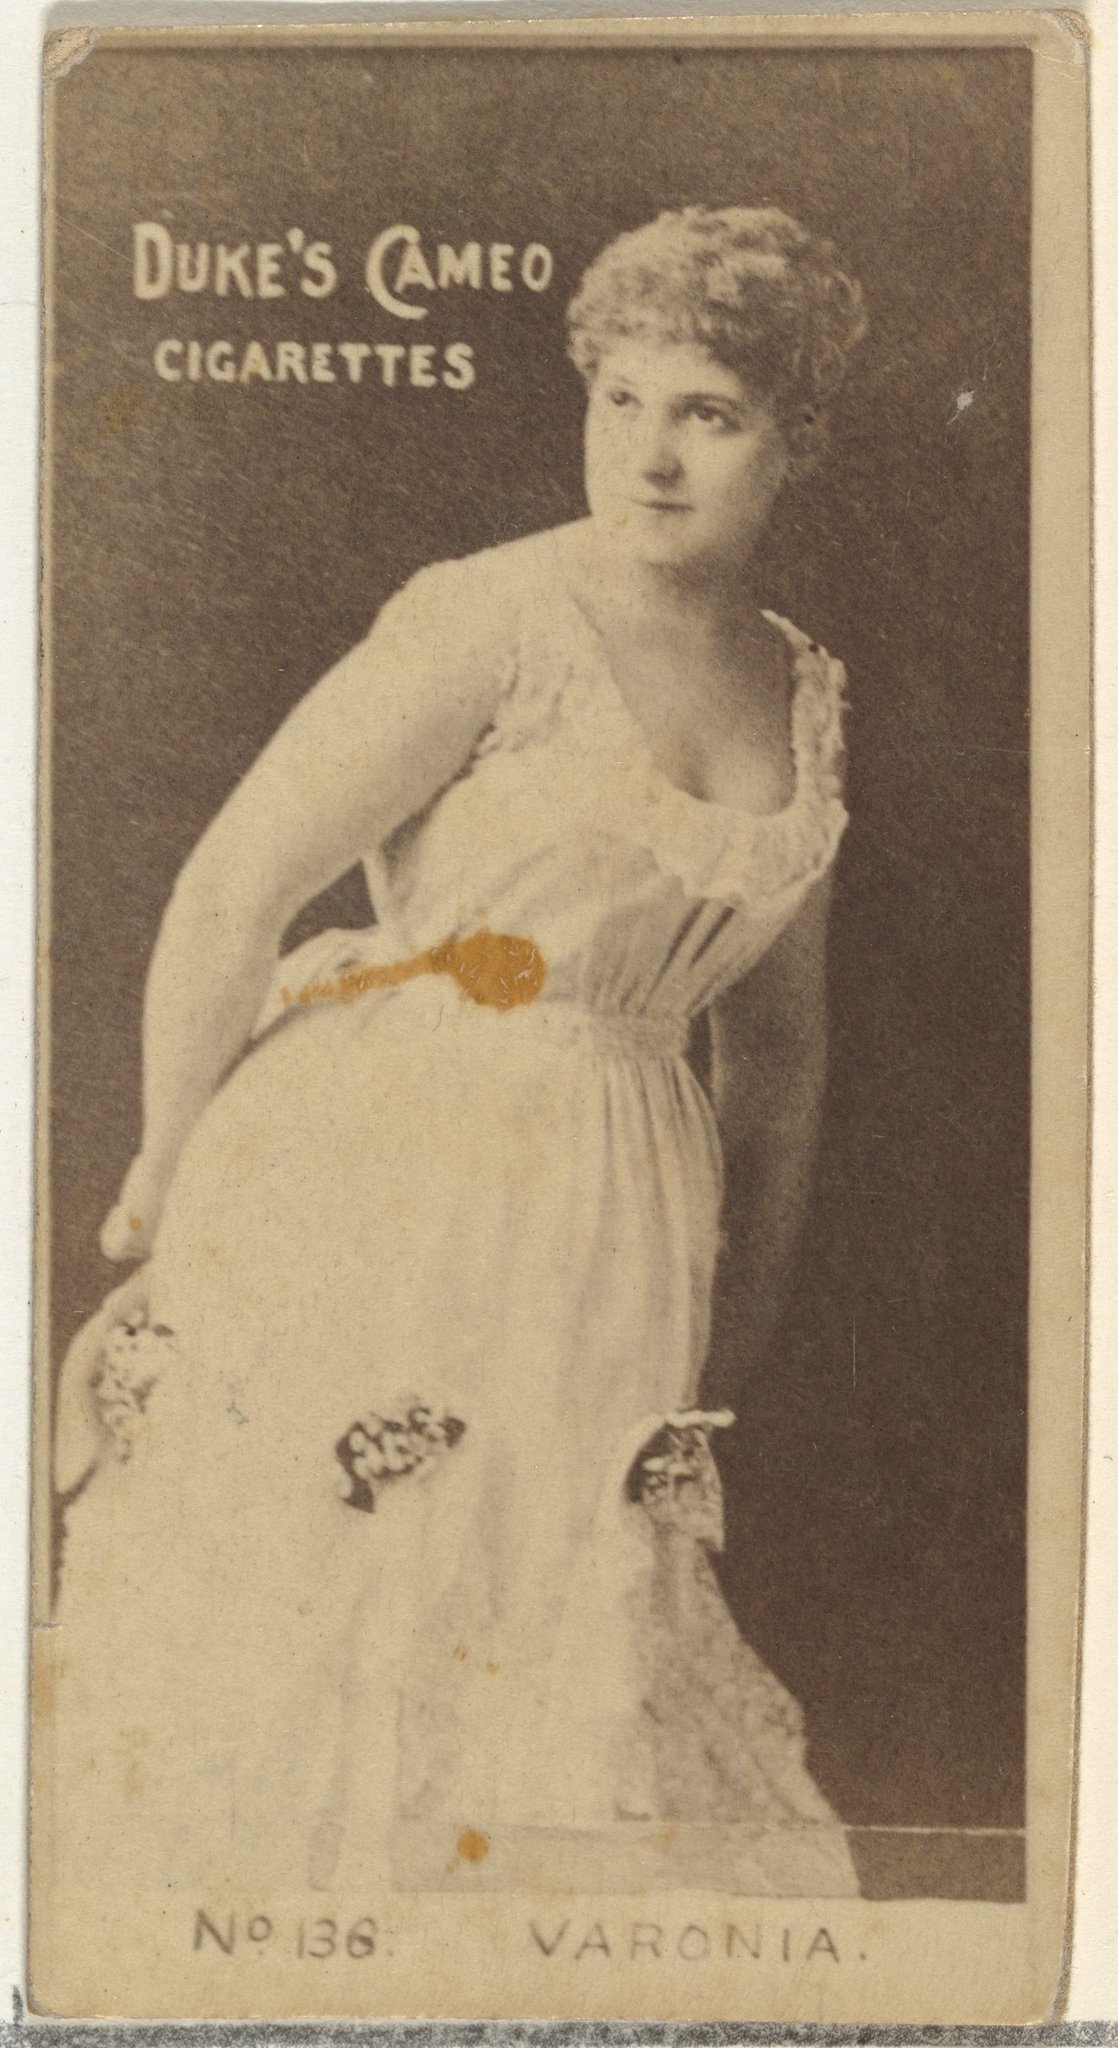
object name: photograph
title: Card Number 136, Irene Varonia, from the Actors and Actresses series (N145-4) issued by Duke Sons & Co. to promote Cameo Cigarettes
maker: w. duke, sons & co.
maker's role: publisher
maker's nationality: american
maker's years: 1870-1920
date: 1880-1889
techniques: albumen silver print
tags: portraits,women,actresses